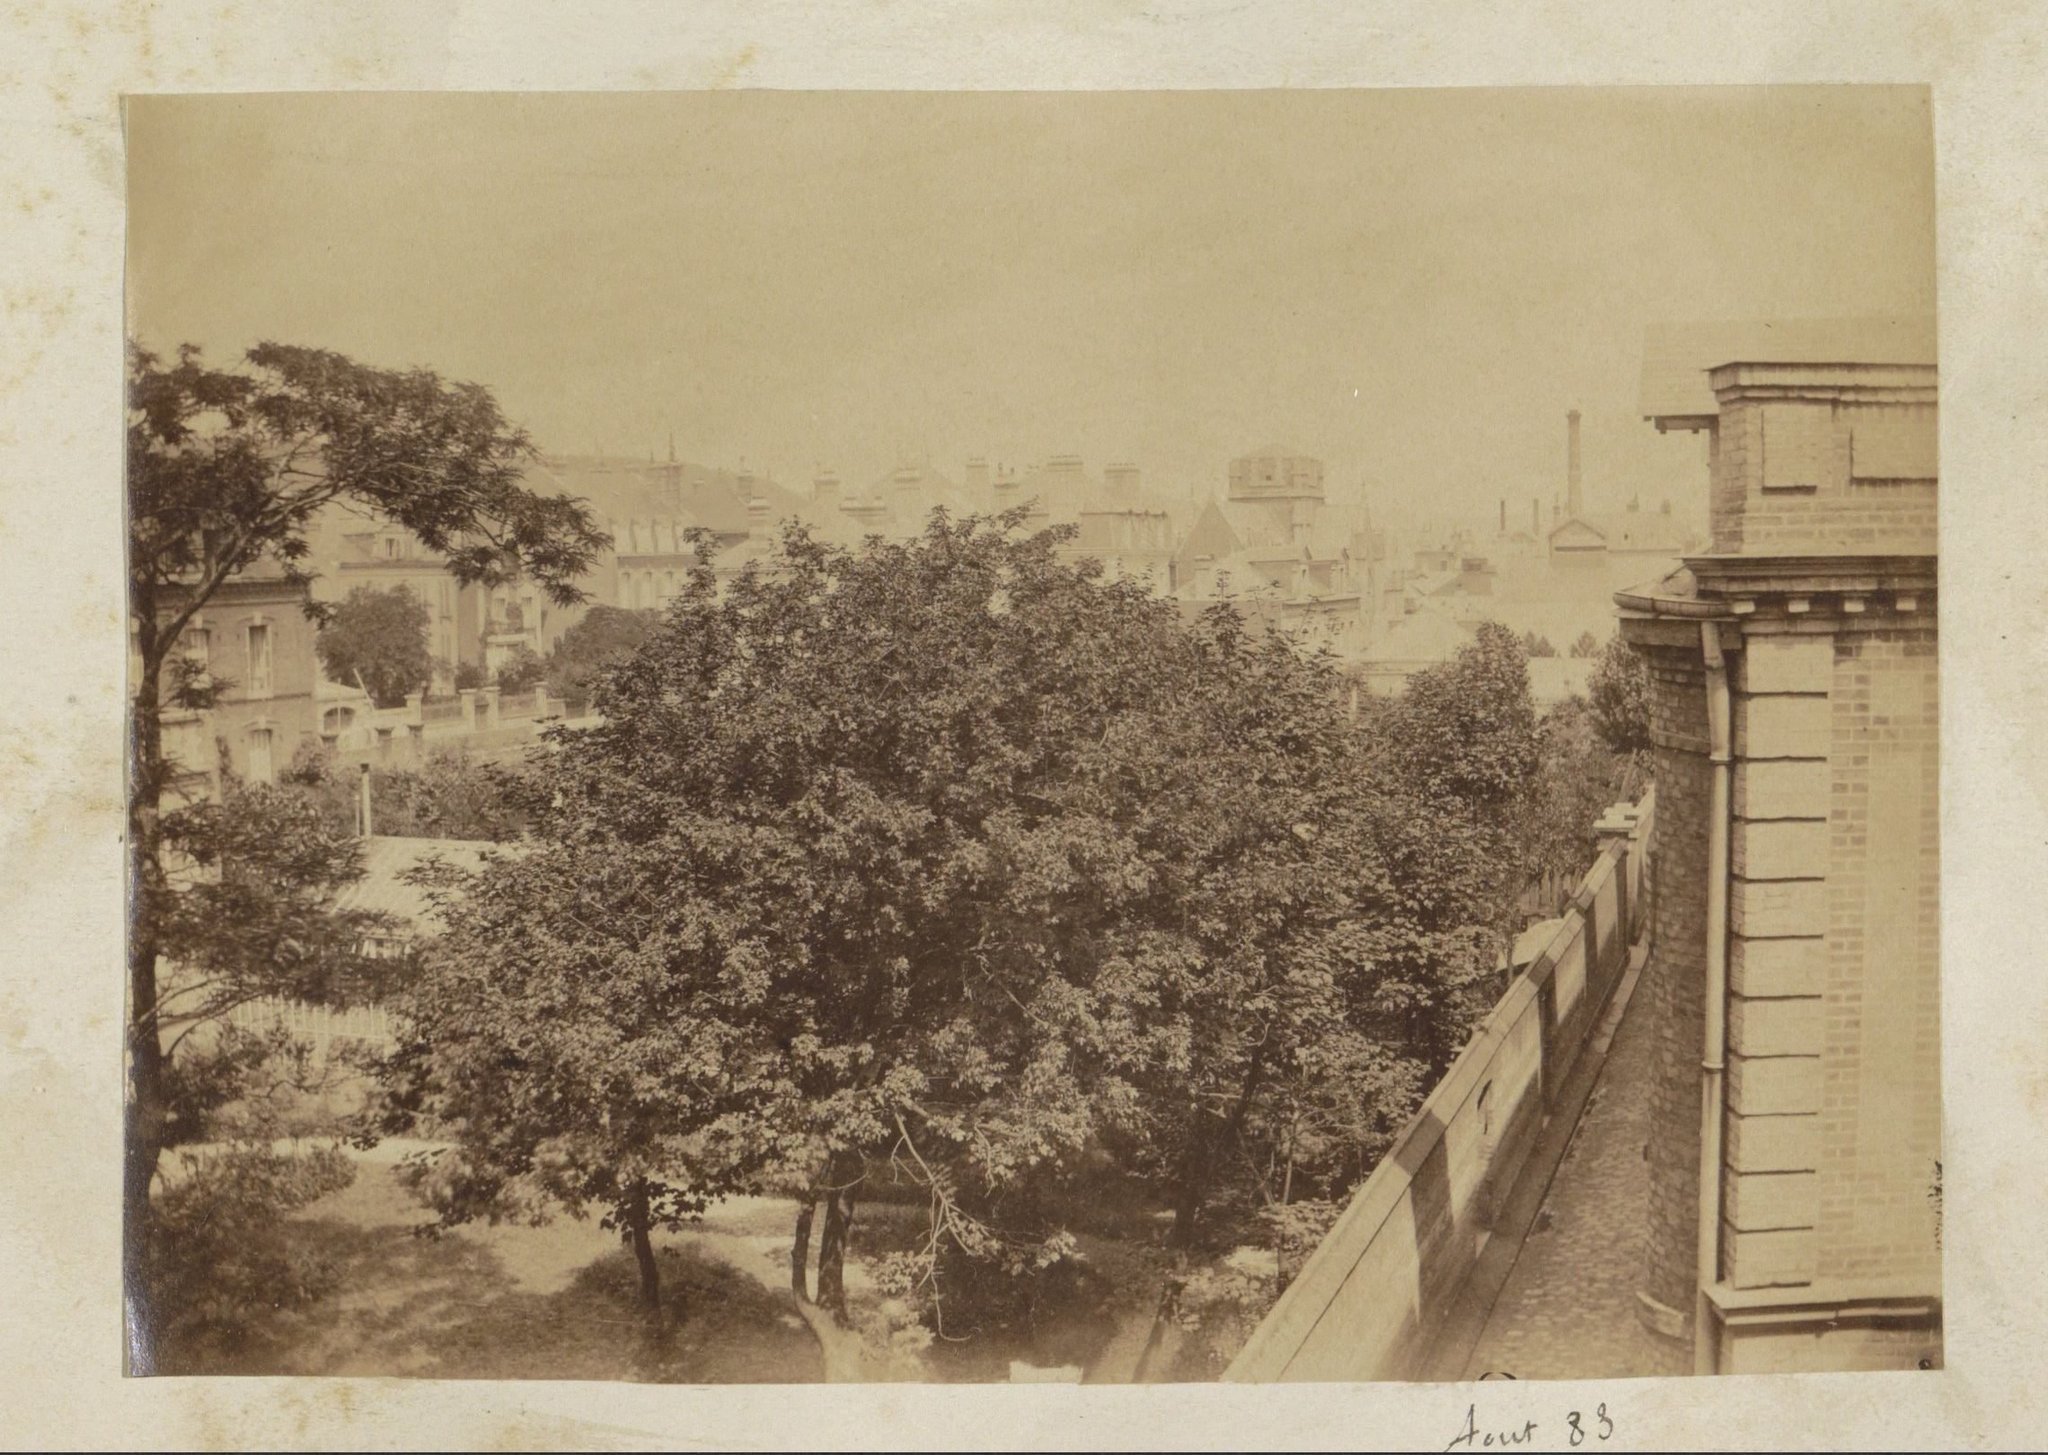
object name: photograph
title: Gezicht op huizen en tuinen in een Franse stad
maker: Anonymous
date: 1808-1883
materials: photographic support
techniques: albumen print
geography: france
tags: prospect of city, town panorama, silhouette of city, france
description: Onderdeel van Album van een Franse amateurfotograaf met opnames van familie, militairen, industrie, landschappen en bezienswaardigheden in Frankrijk.